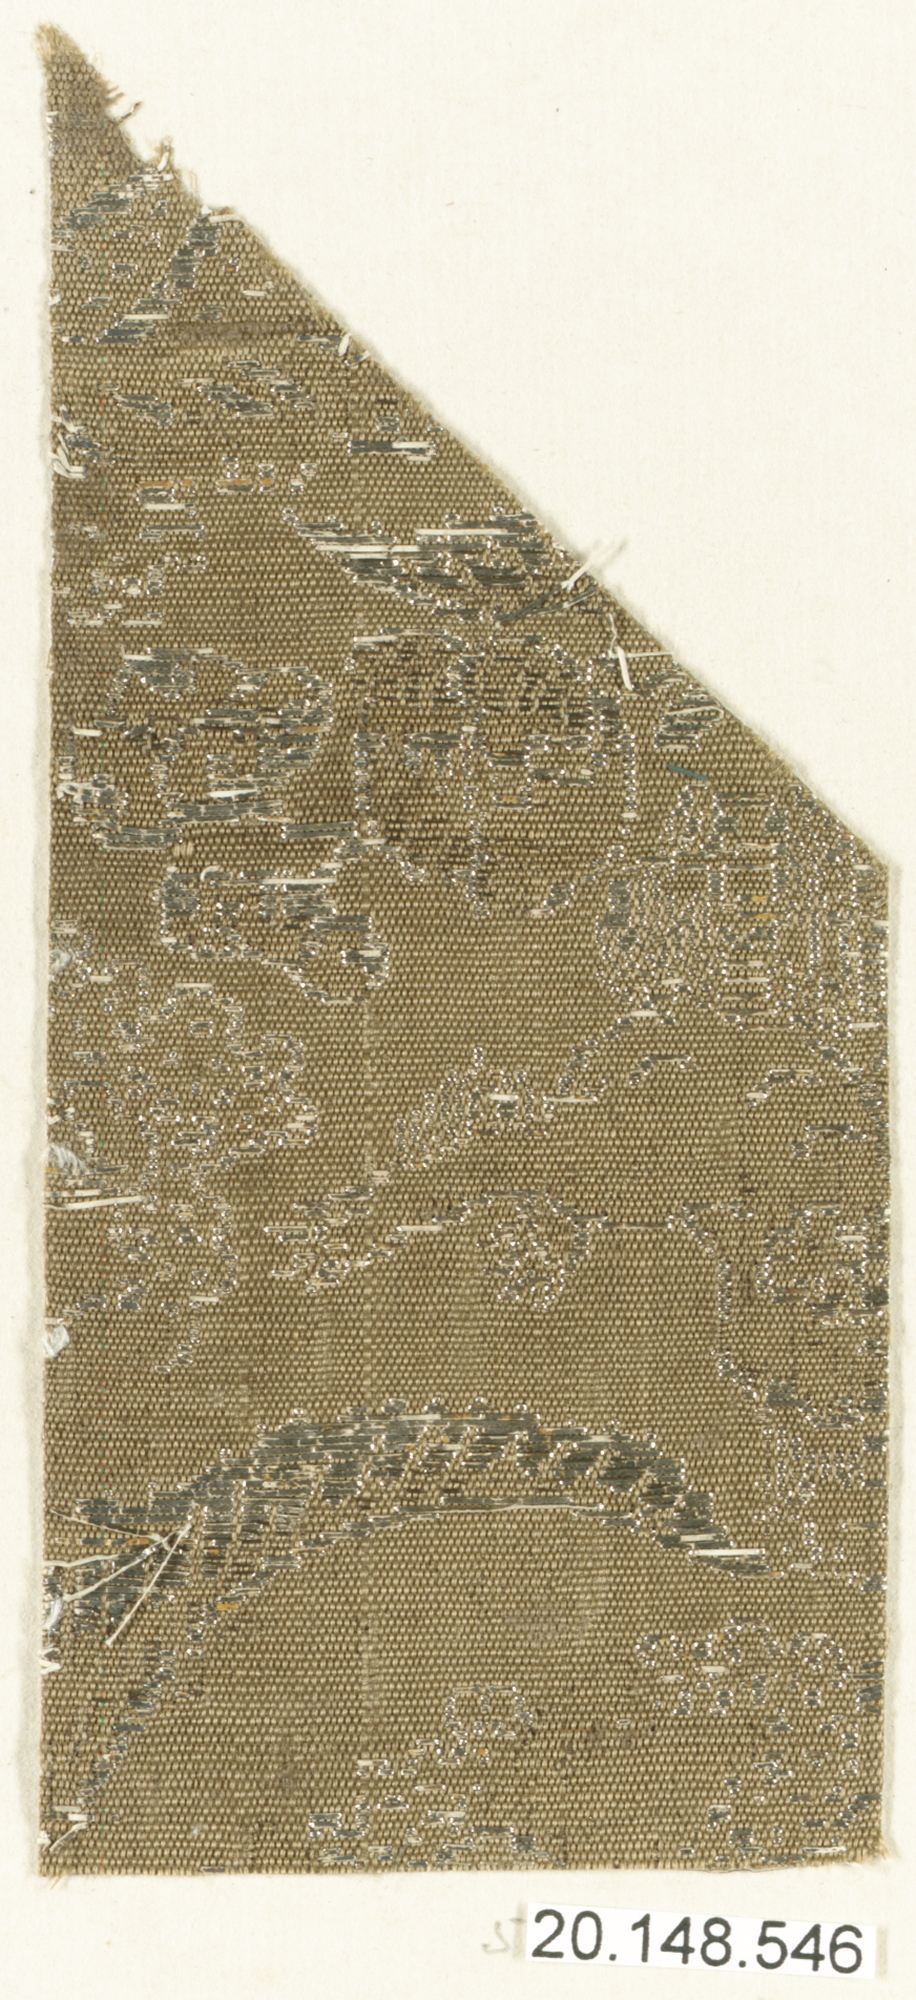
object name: piece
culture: chinese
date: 1701-1800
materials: silk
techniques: compound weave